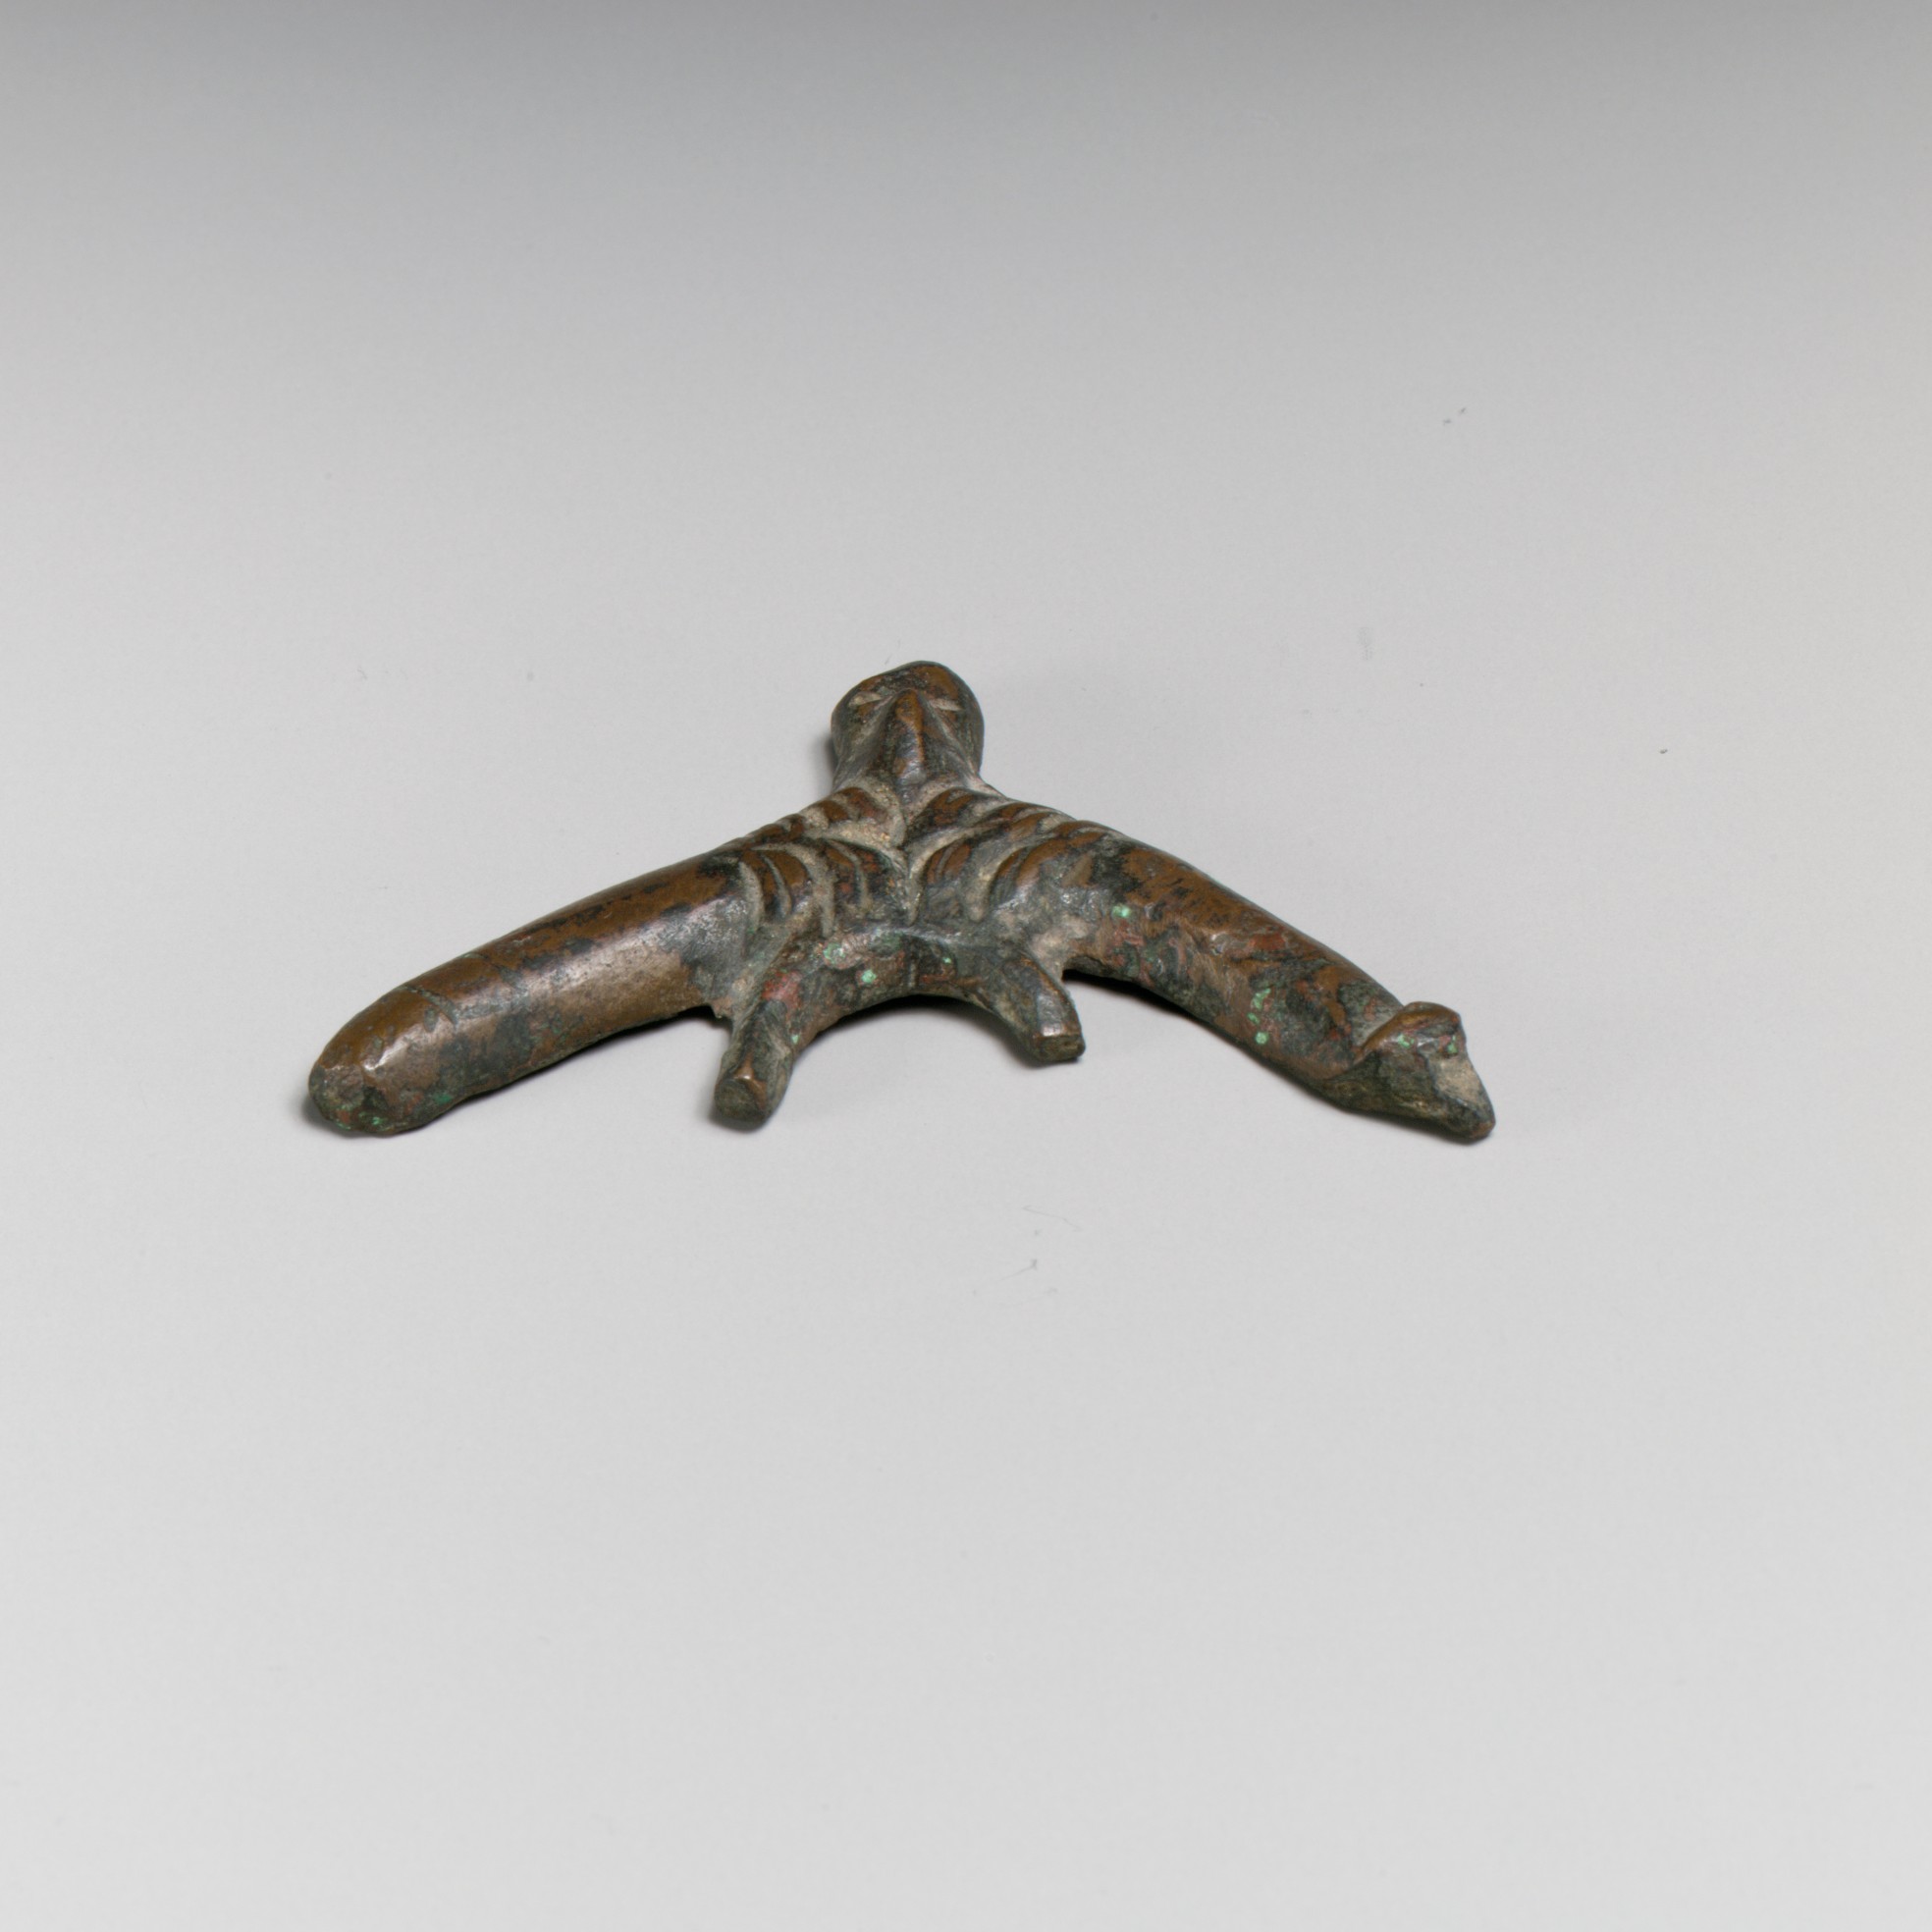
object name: amulet, grotesque ornament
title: Bronze phallic amulet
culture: roman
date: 1-100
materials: bronze